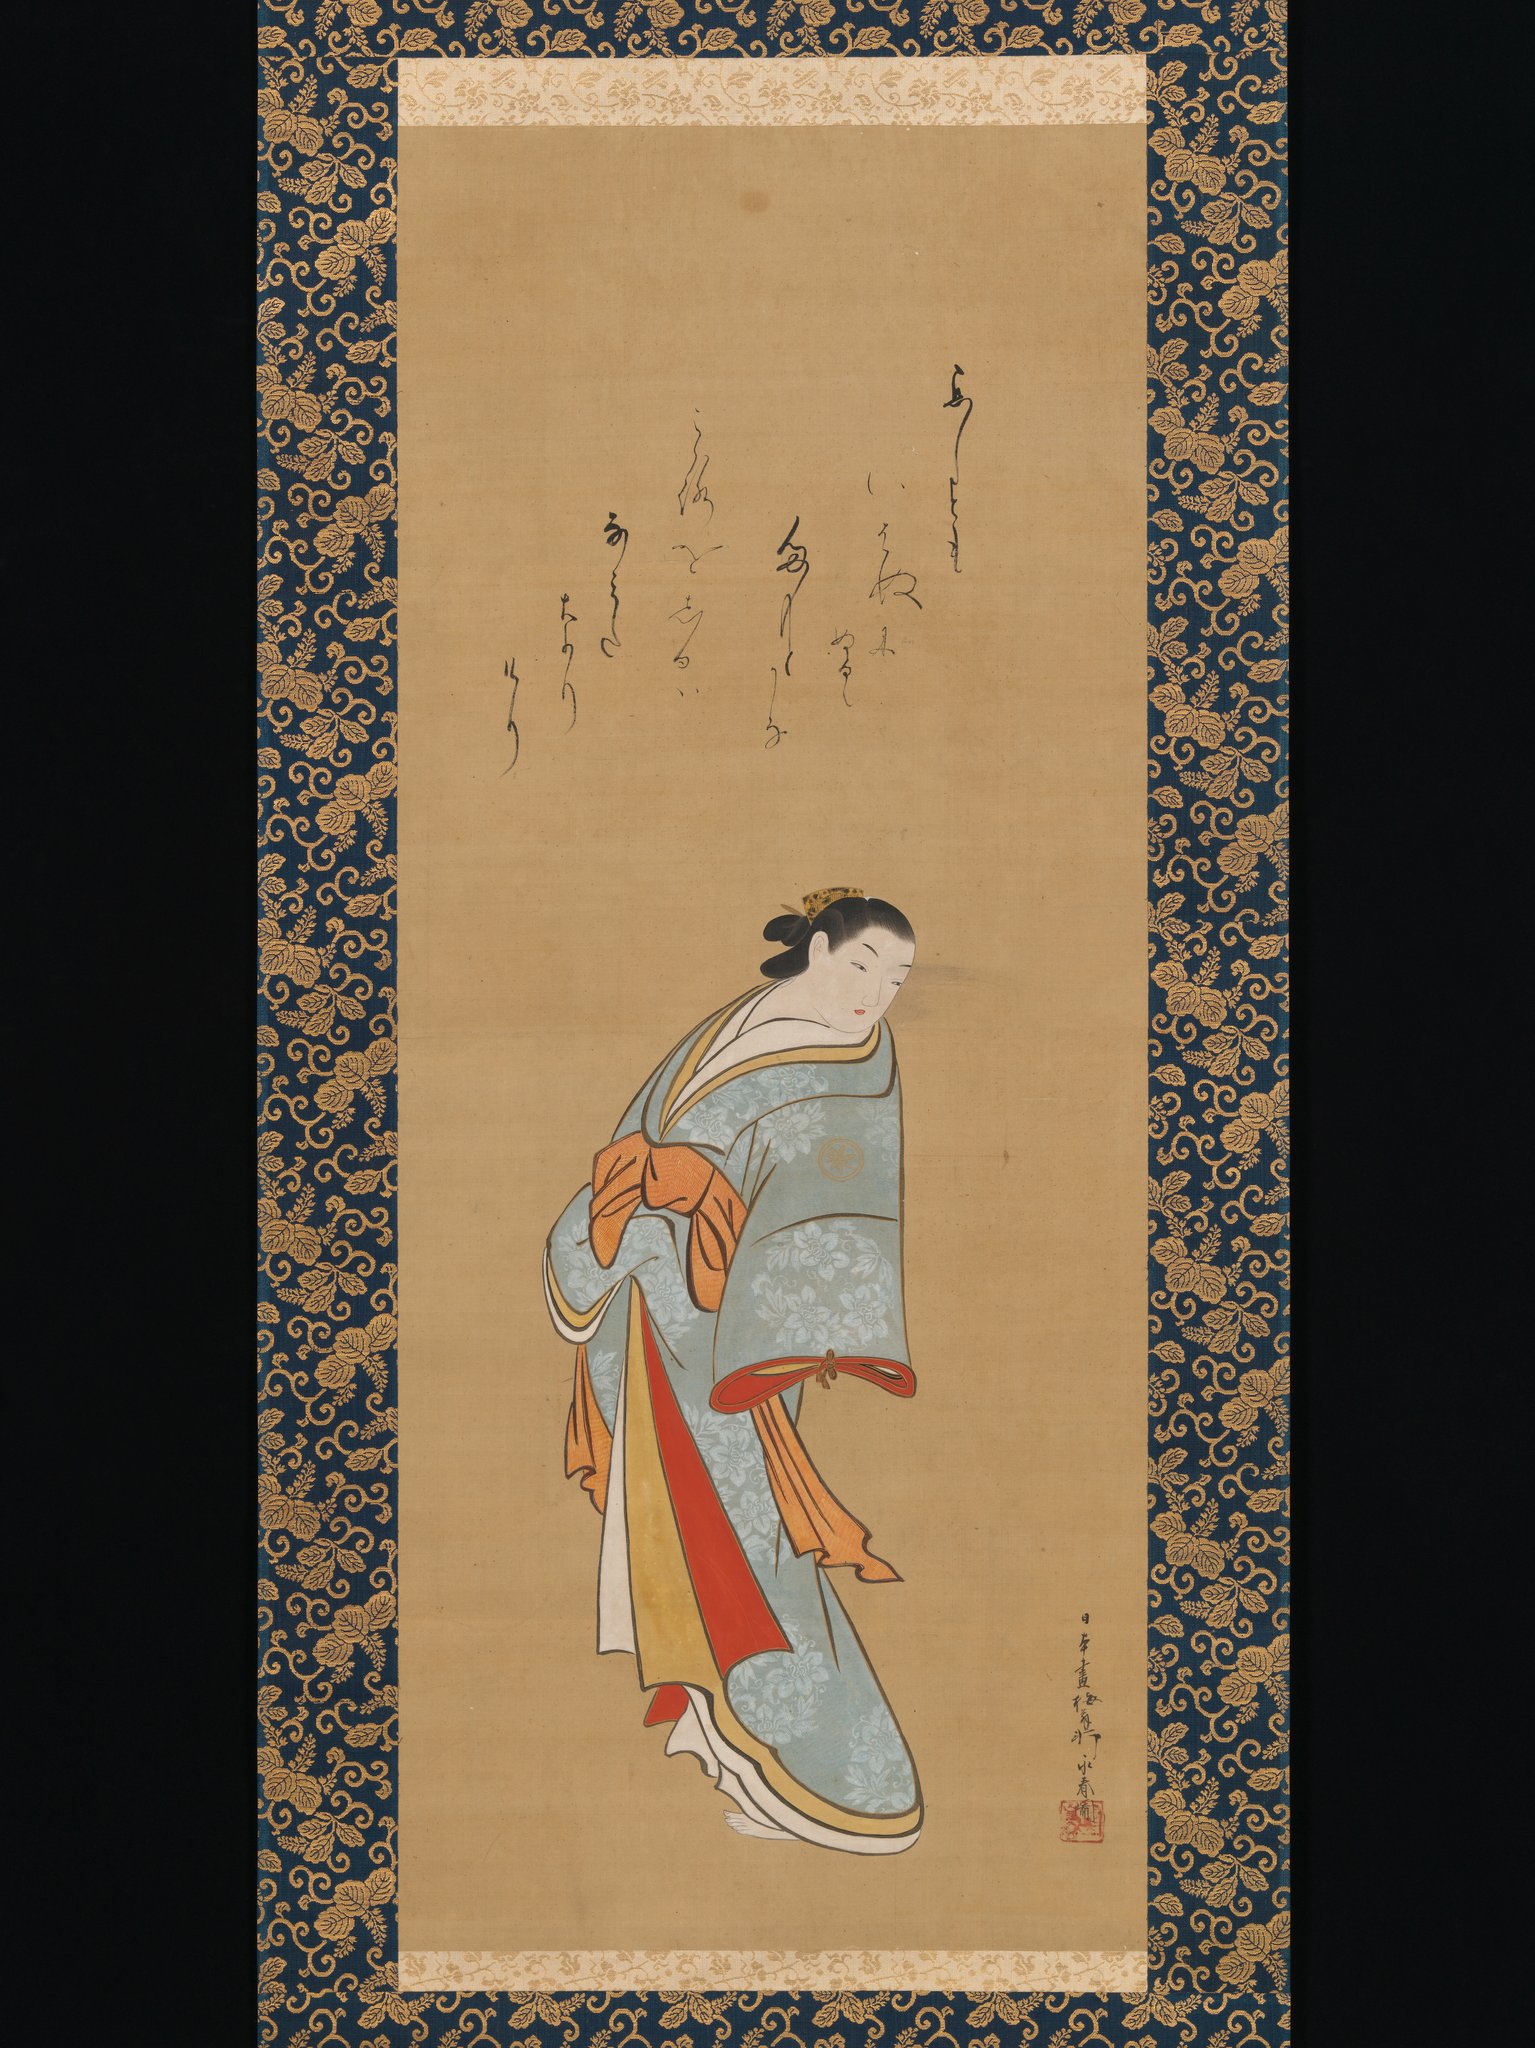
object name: hanging scroll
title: Standing Courtesan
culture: japanese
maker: baiōken eishun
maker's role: artist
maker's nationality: japanese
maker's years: 1710-1730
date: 1720-1729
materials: ink, silk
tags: poetry,women